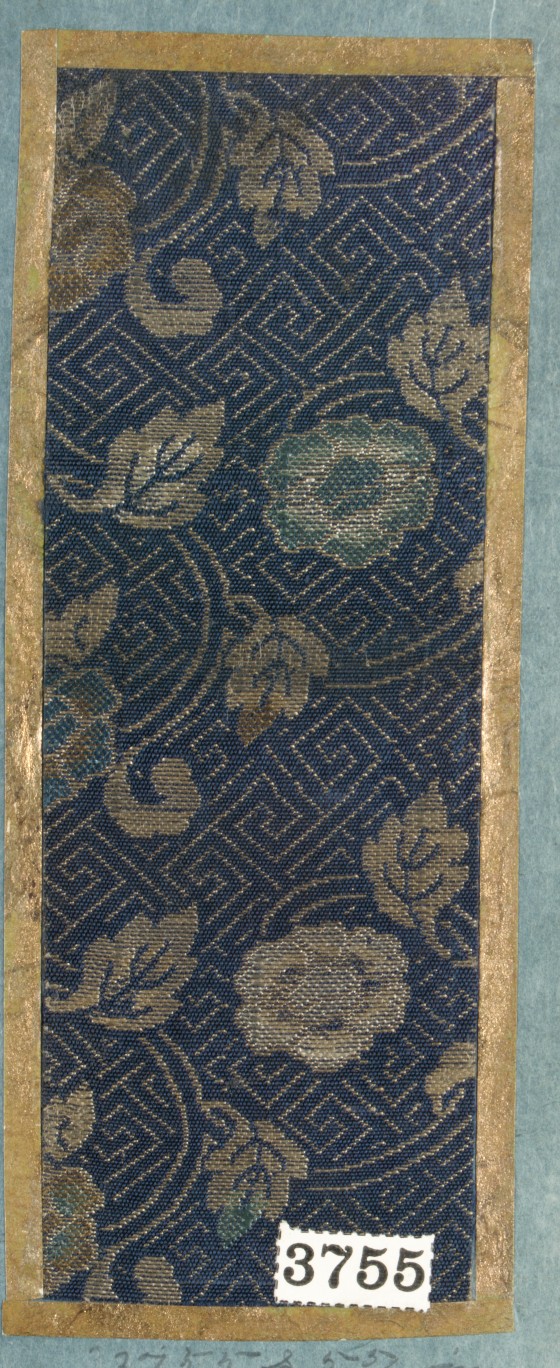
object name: sample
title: Textile Sample from Sample Book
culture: japanese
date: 1801-1900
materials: silk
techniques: tapestry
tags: flowers